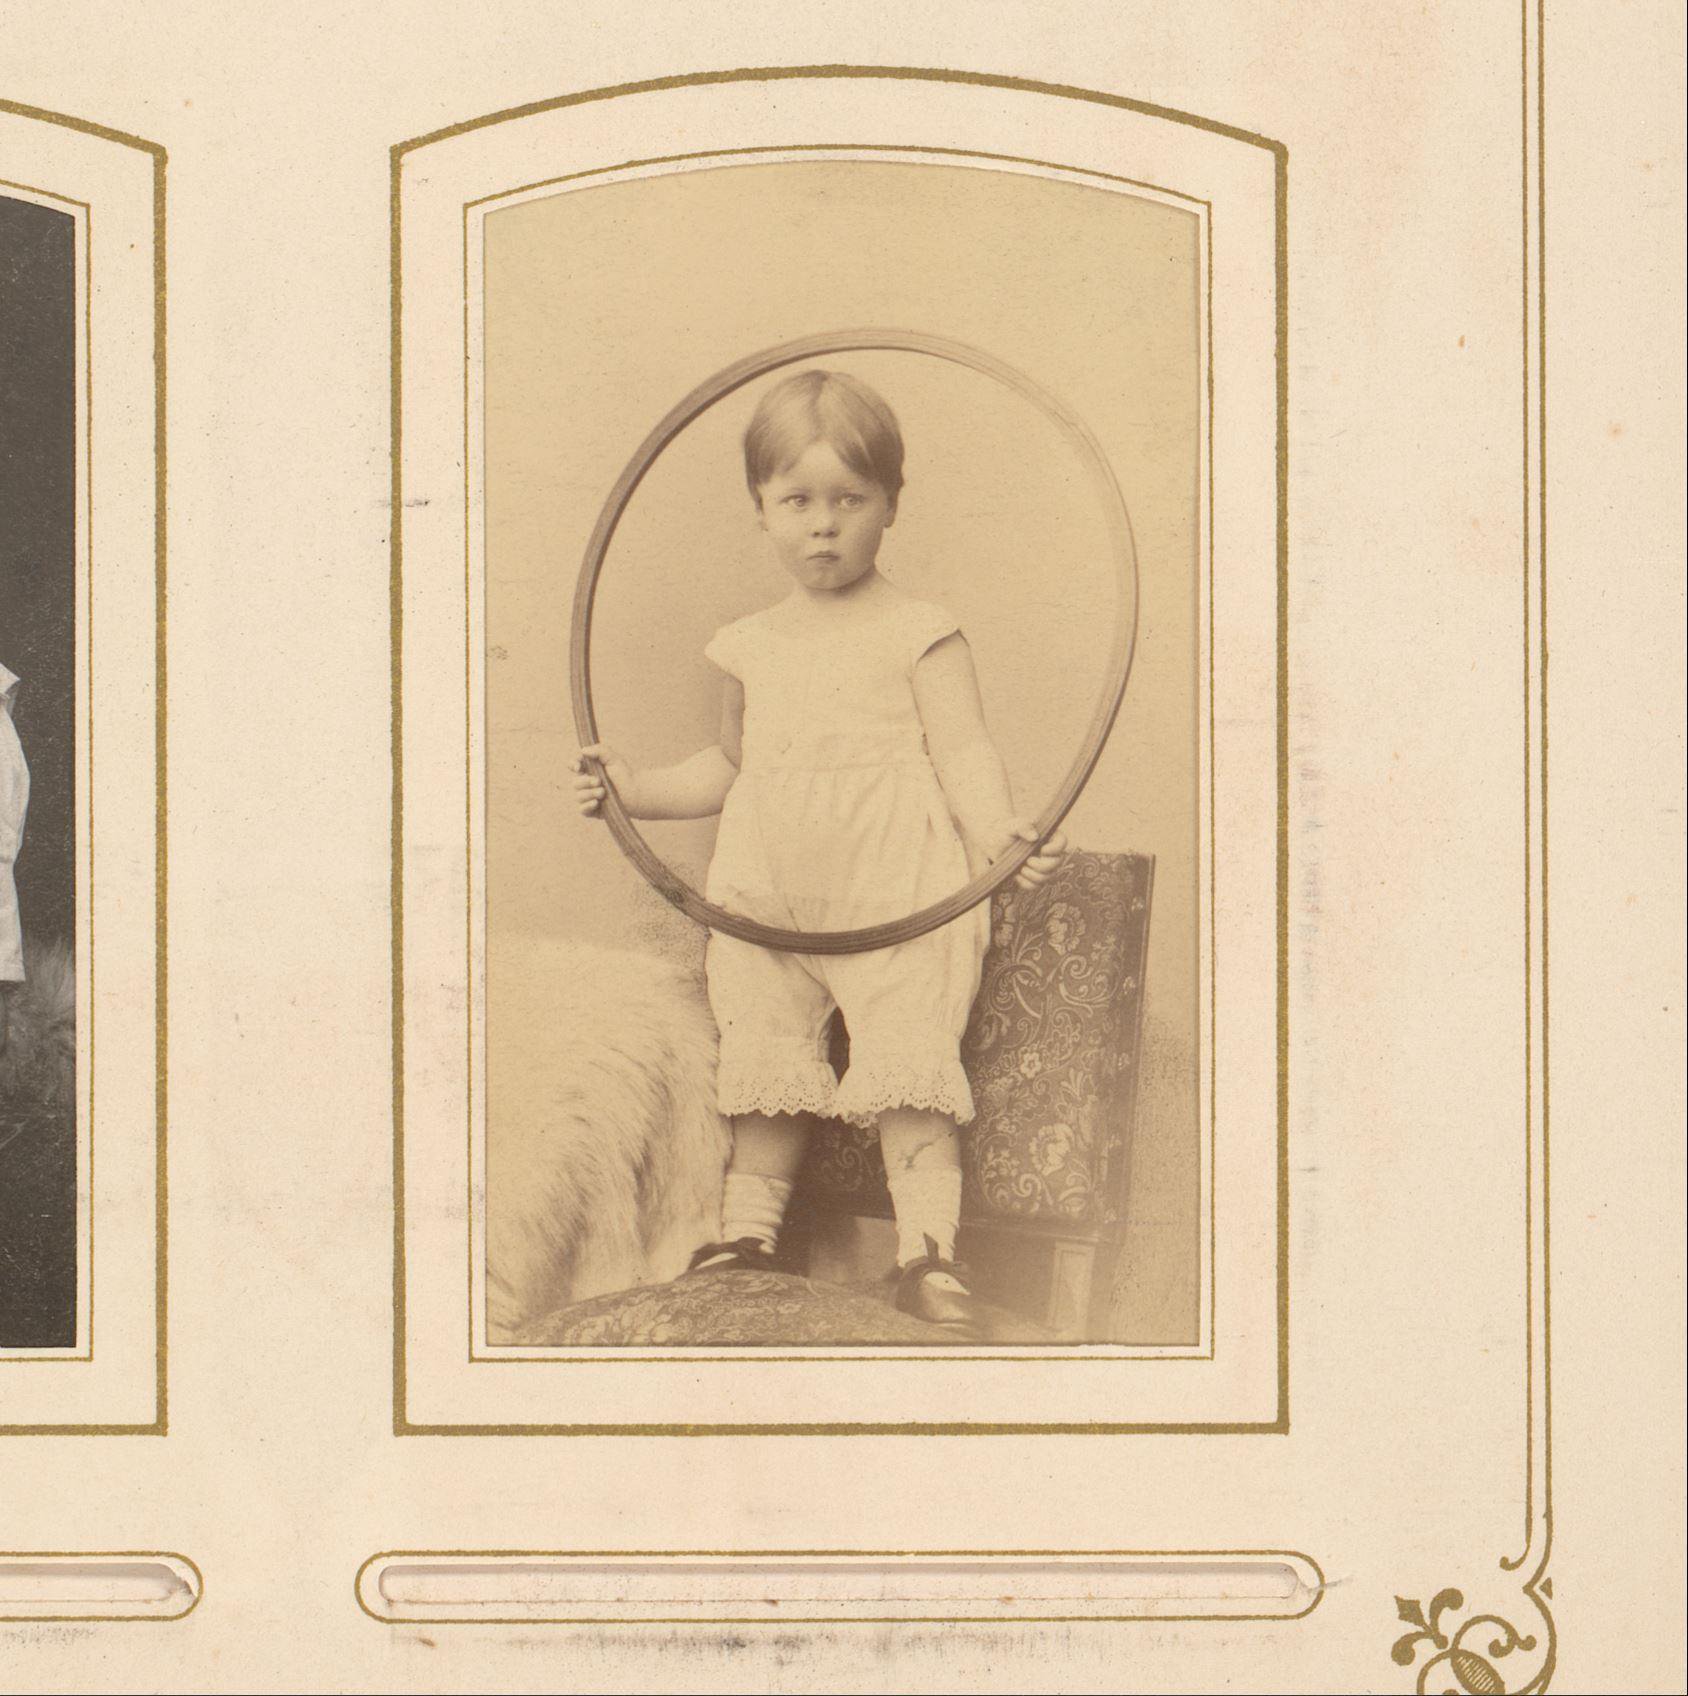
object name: carte de visite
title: Portret van een kind op een stoel met een hoepel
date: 1892-1900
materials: cardboard, photographic support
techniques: albumen print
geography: bremen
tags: historical persons, (bowling a) hoop, tot, toddler ~ the ages of man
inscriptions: inscription: ‘Müller & Pilgram/ Emil Tiedemann Nachf./ Bremen/ Richtweg 12, parterre./ Fernsprecher No. 984./ Vergrösserungen bis zur Lebensgrosse nach/ jedem, noch so stark verblichenen Bilde/ in Schwarz, Pastell, Aquarell und Oel.’, name: ‘Oscar’